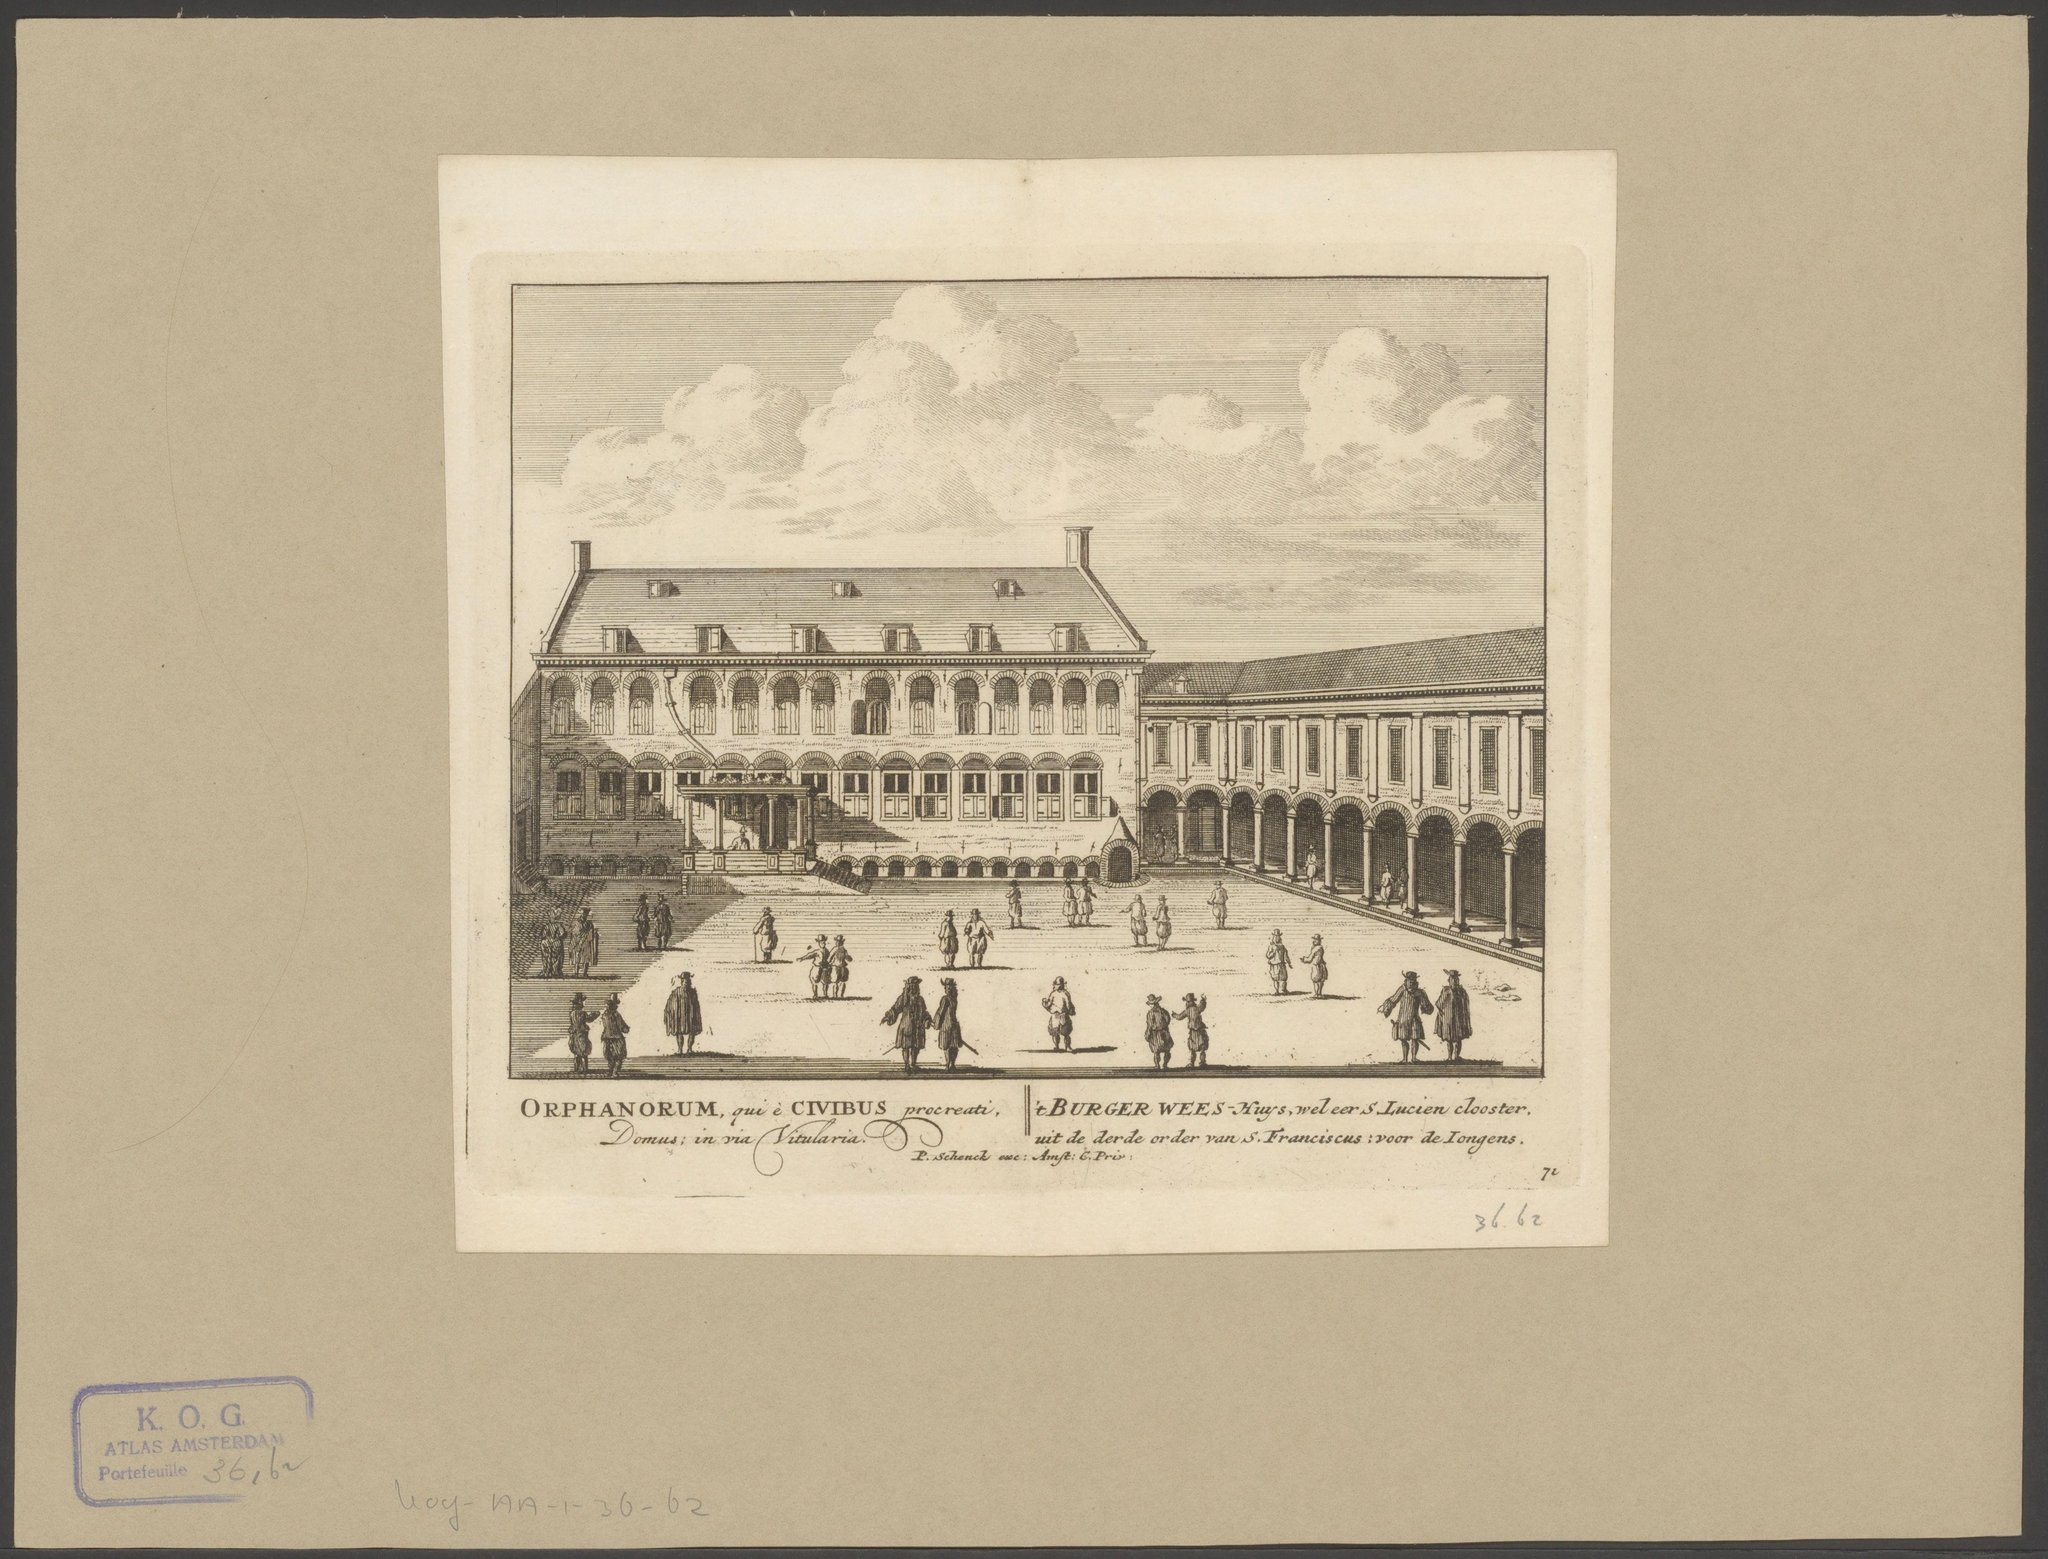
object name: print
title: Gezicht op de binnenplaats van het Burgerweeshuis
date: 1710-1766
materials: paper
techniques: engraving, etching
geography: amsterdam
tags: public welfare, courtyard, orphanage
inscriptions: collector's mark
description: Gezicht op het jongenshuis van het Burgerweeshuis te Amsterdam. Op de binnenplaats verschillende figuren. Onder de voorstelling de titel in het Latijn en Nederlands. Rechtsonder genummerd: 71. Onderwerpsrubriek binnen de Atlas Amsterdam: Armwezen en liefdadige instellingen: I. Stadsinrichtingen: Burgerweeshuis.